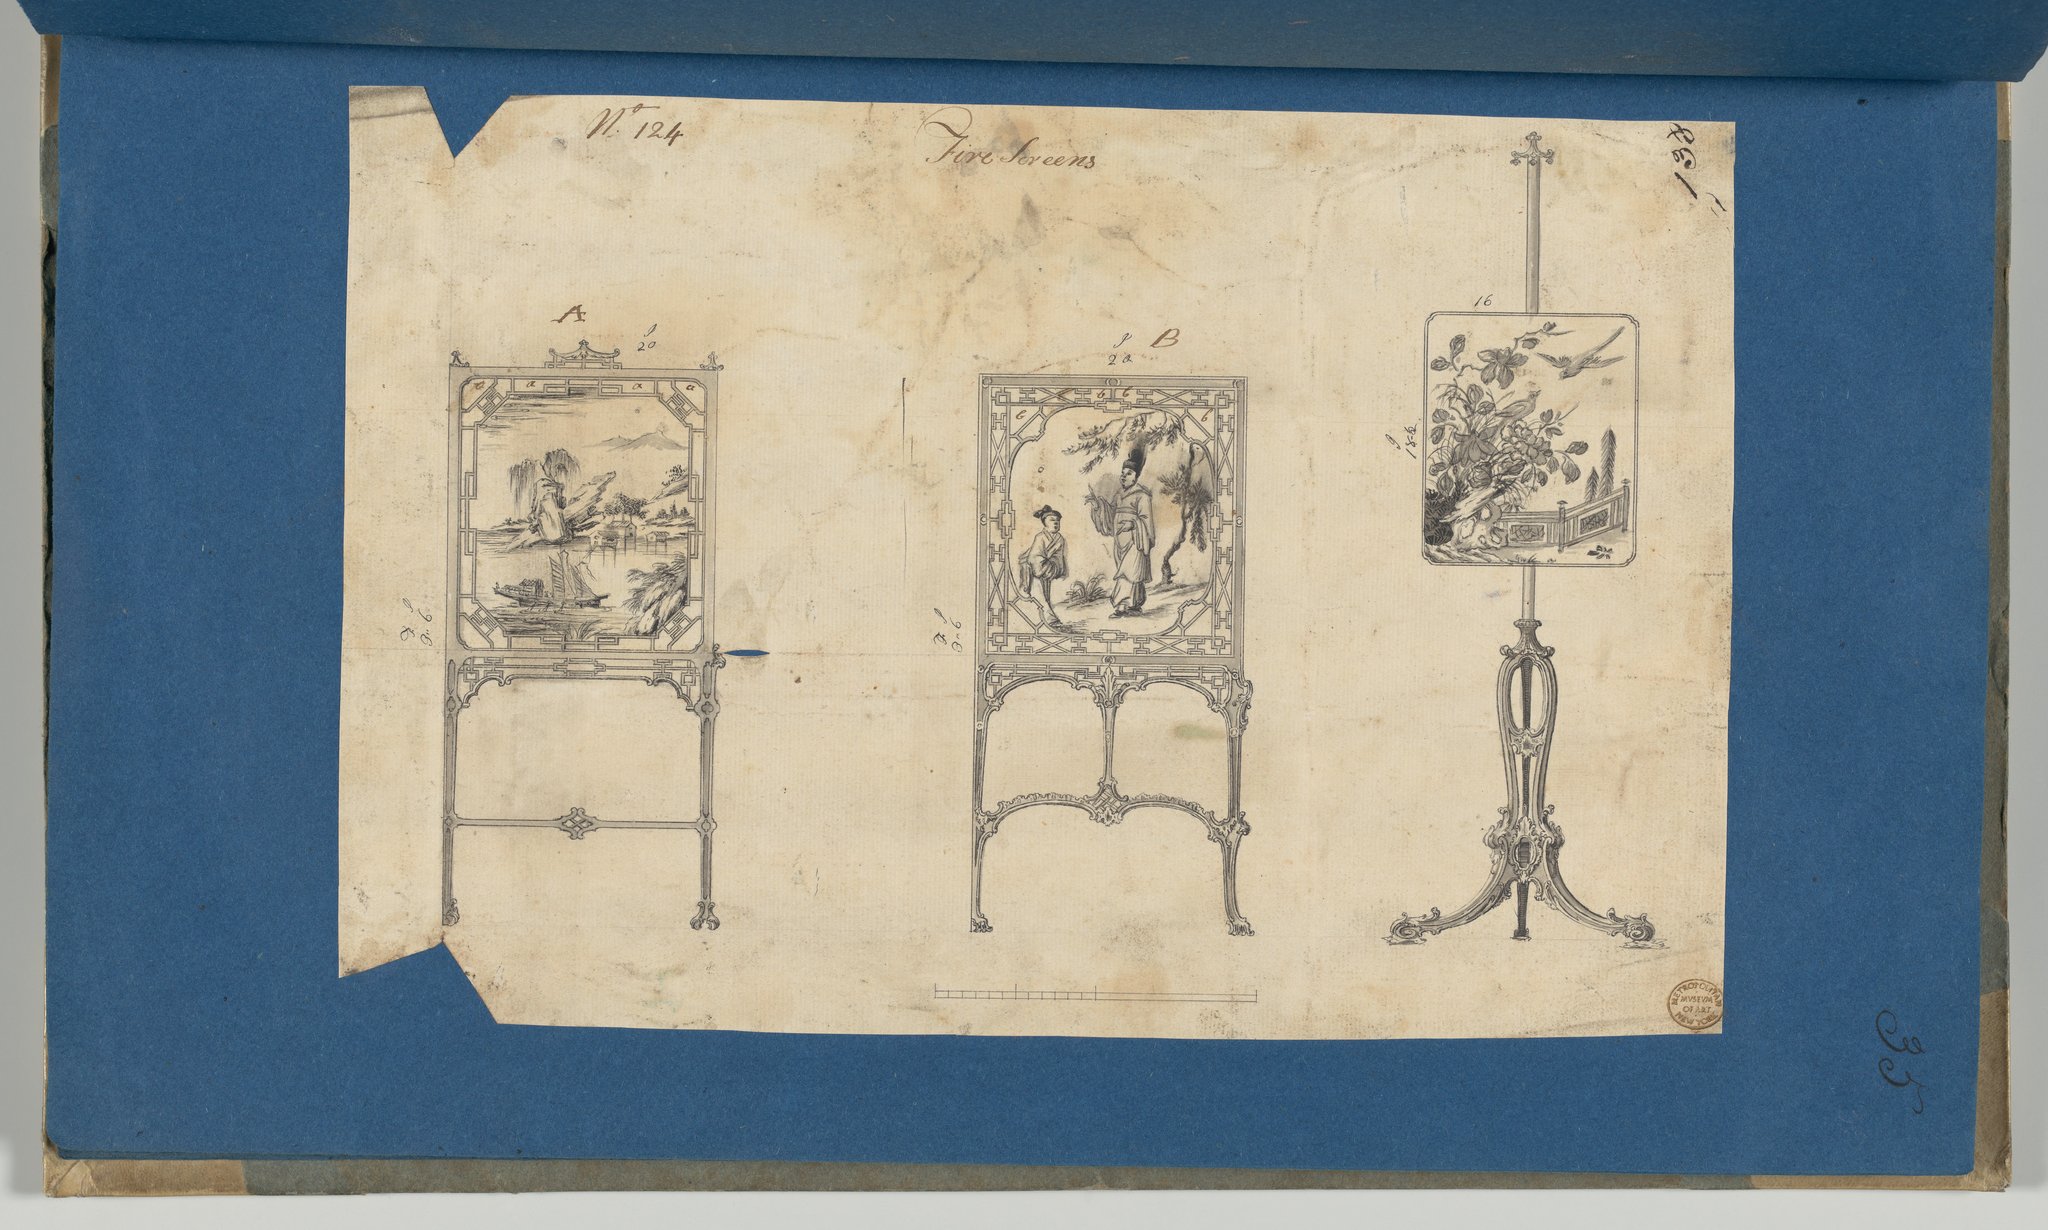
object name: drawing ornament architecture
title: Fire Screens, in Chippendale Drawings, Vol. I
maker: thomas chippendale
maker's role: artist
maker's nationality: british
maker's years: 1718-1779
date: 1754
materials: ink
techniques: wash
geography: london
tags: human figures,chinoiserie,screens